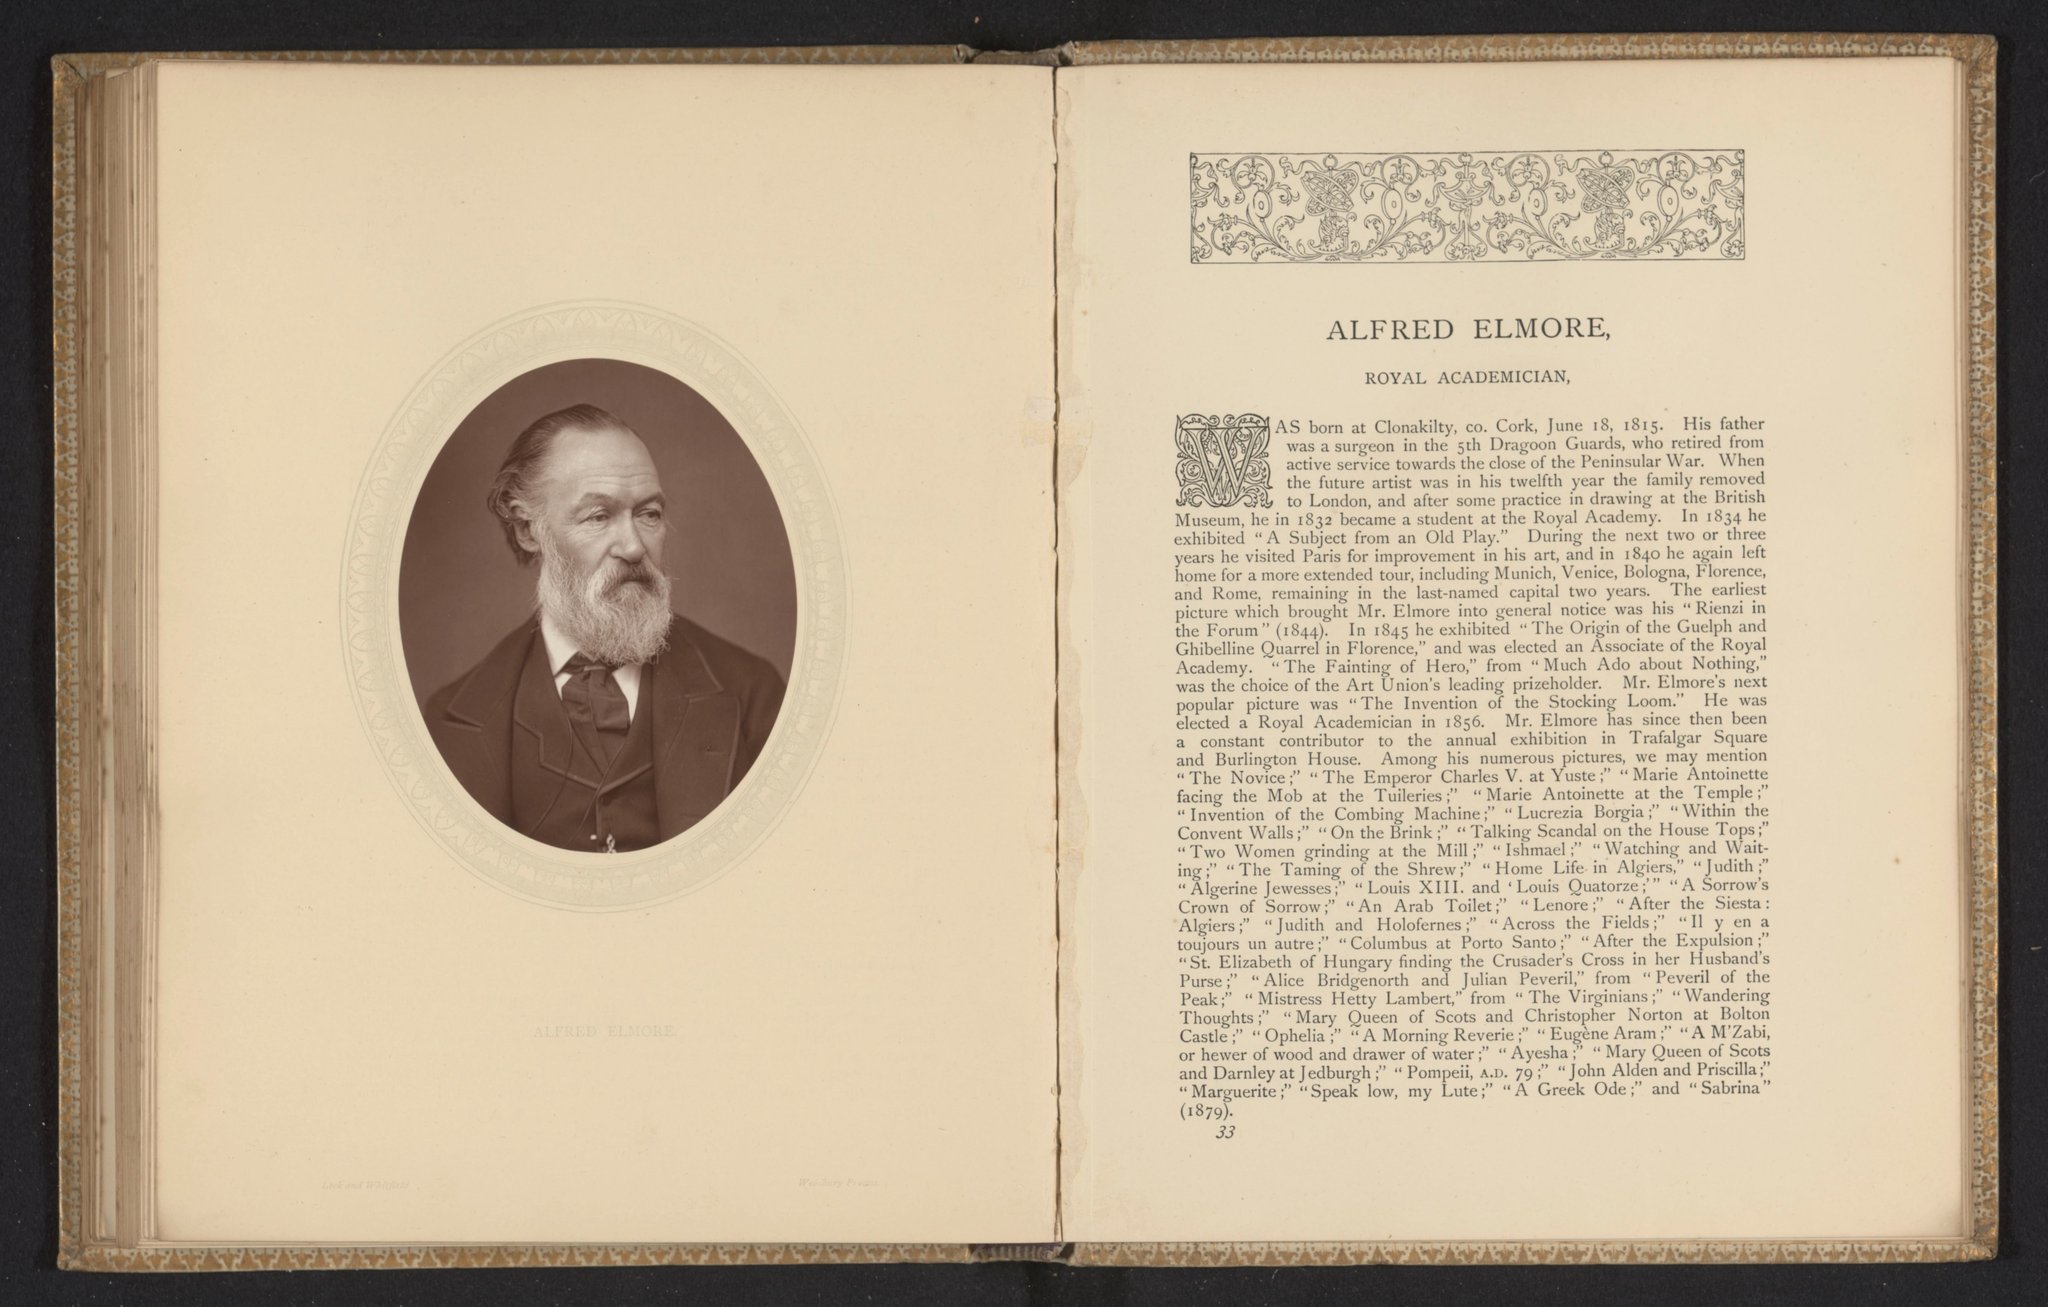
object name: photomechanical print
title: Alfred Elmore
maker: Anonymous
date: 1876-1881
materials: paper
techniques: woodburytype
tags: alfred elmore, portrait, self-portrait of painter, historical persons (portraits and scenes from the life) (+ (full) bust portrait)